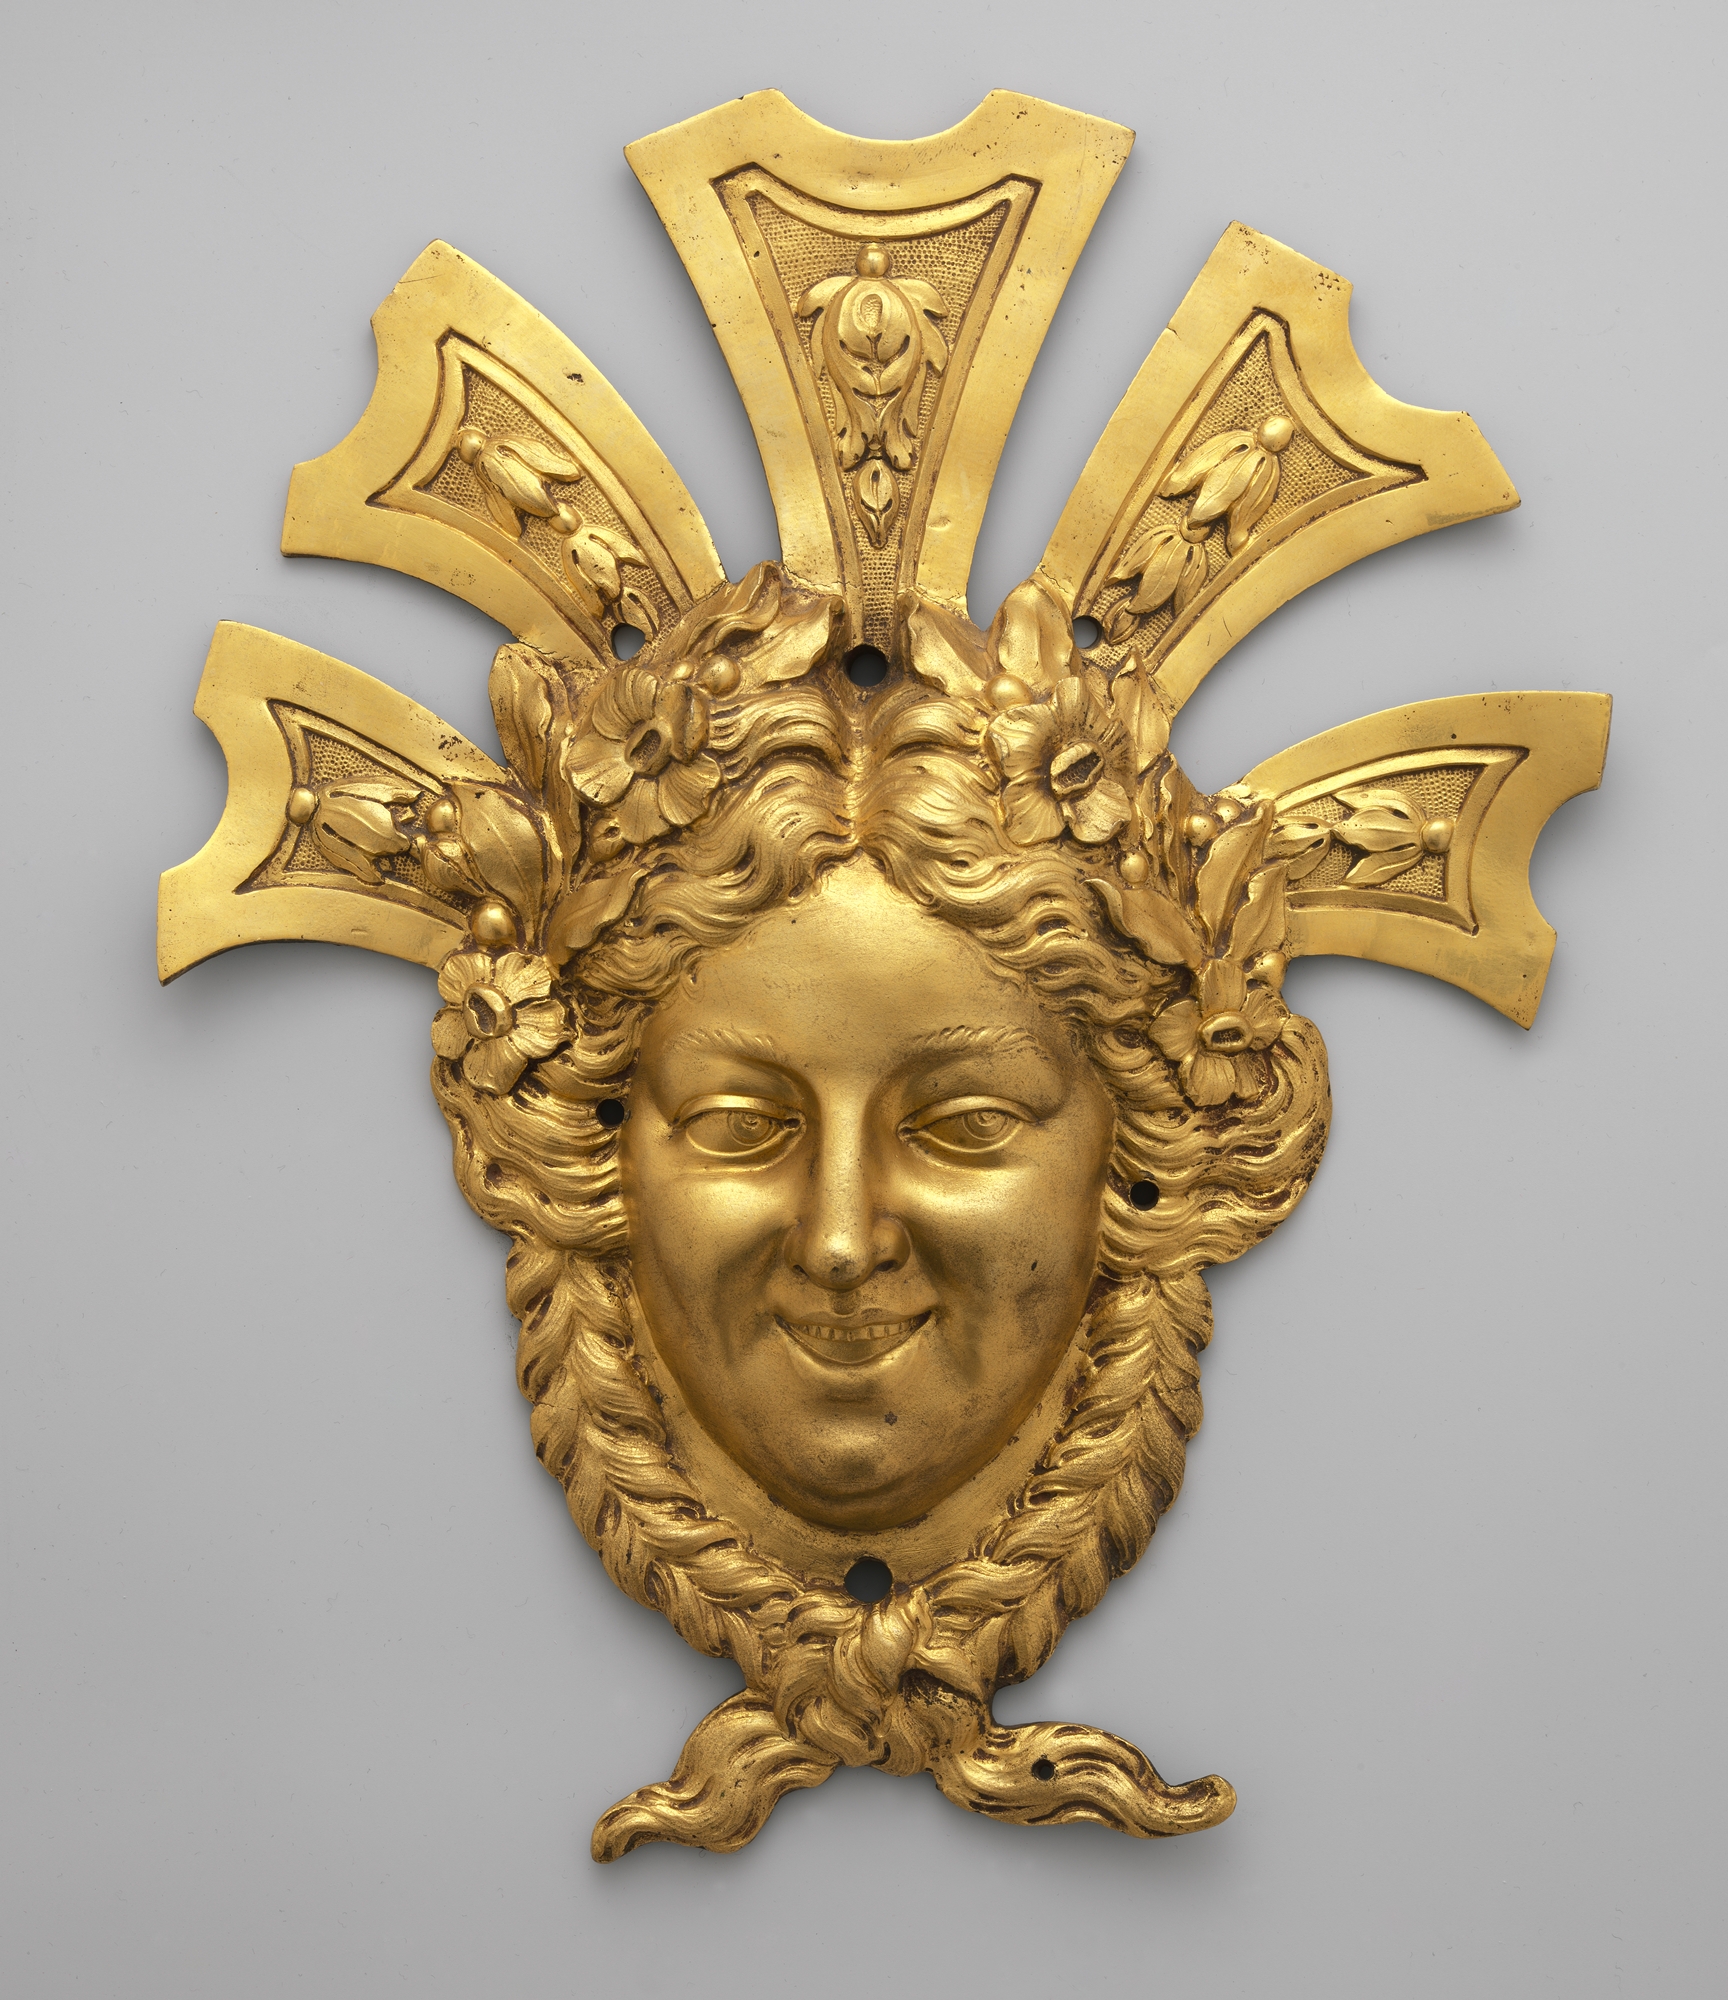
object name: mask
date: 1601-1800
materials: gilt bronze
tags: masks,flowers